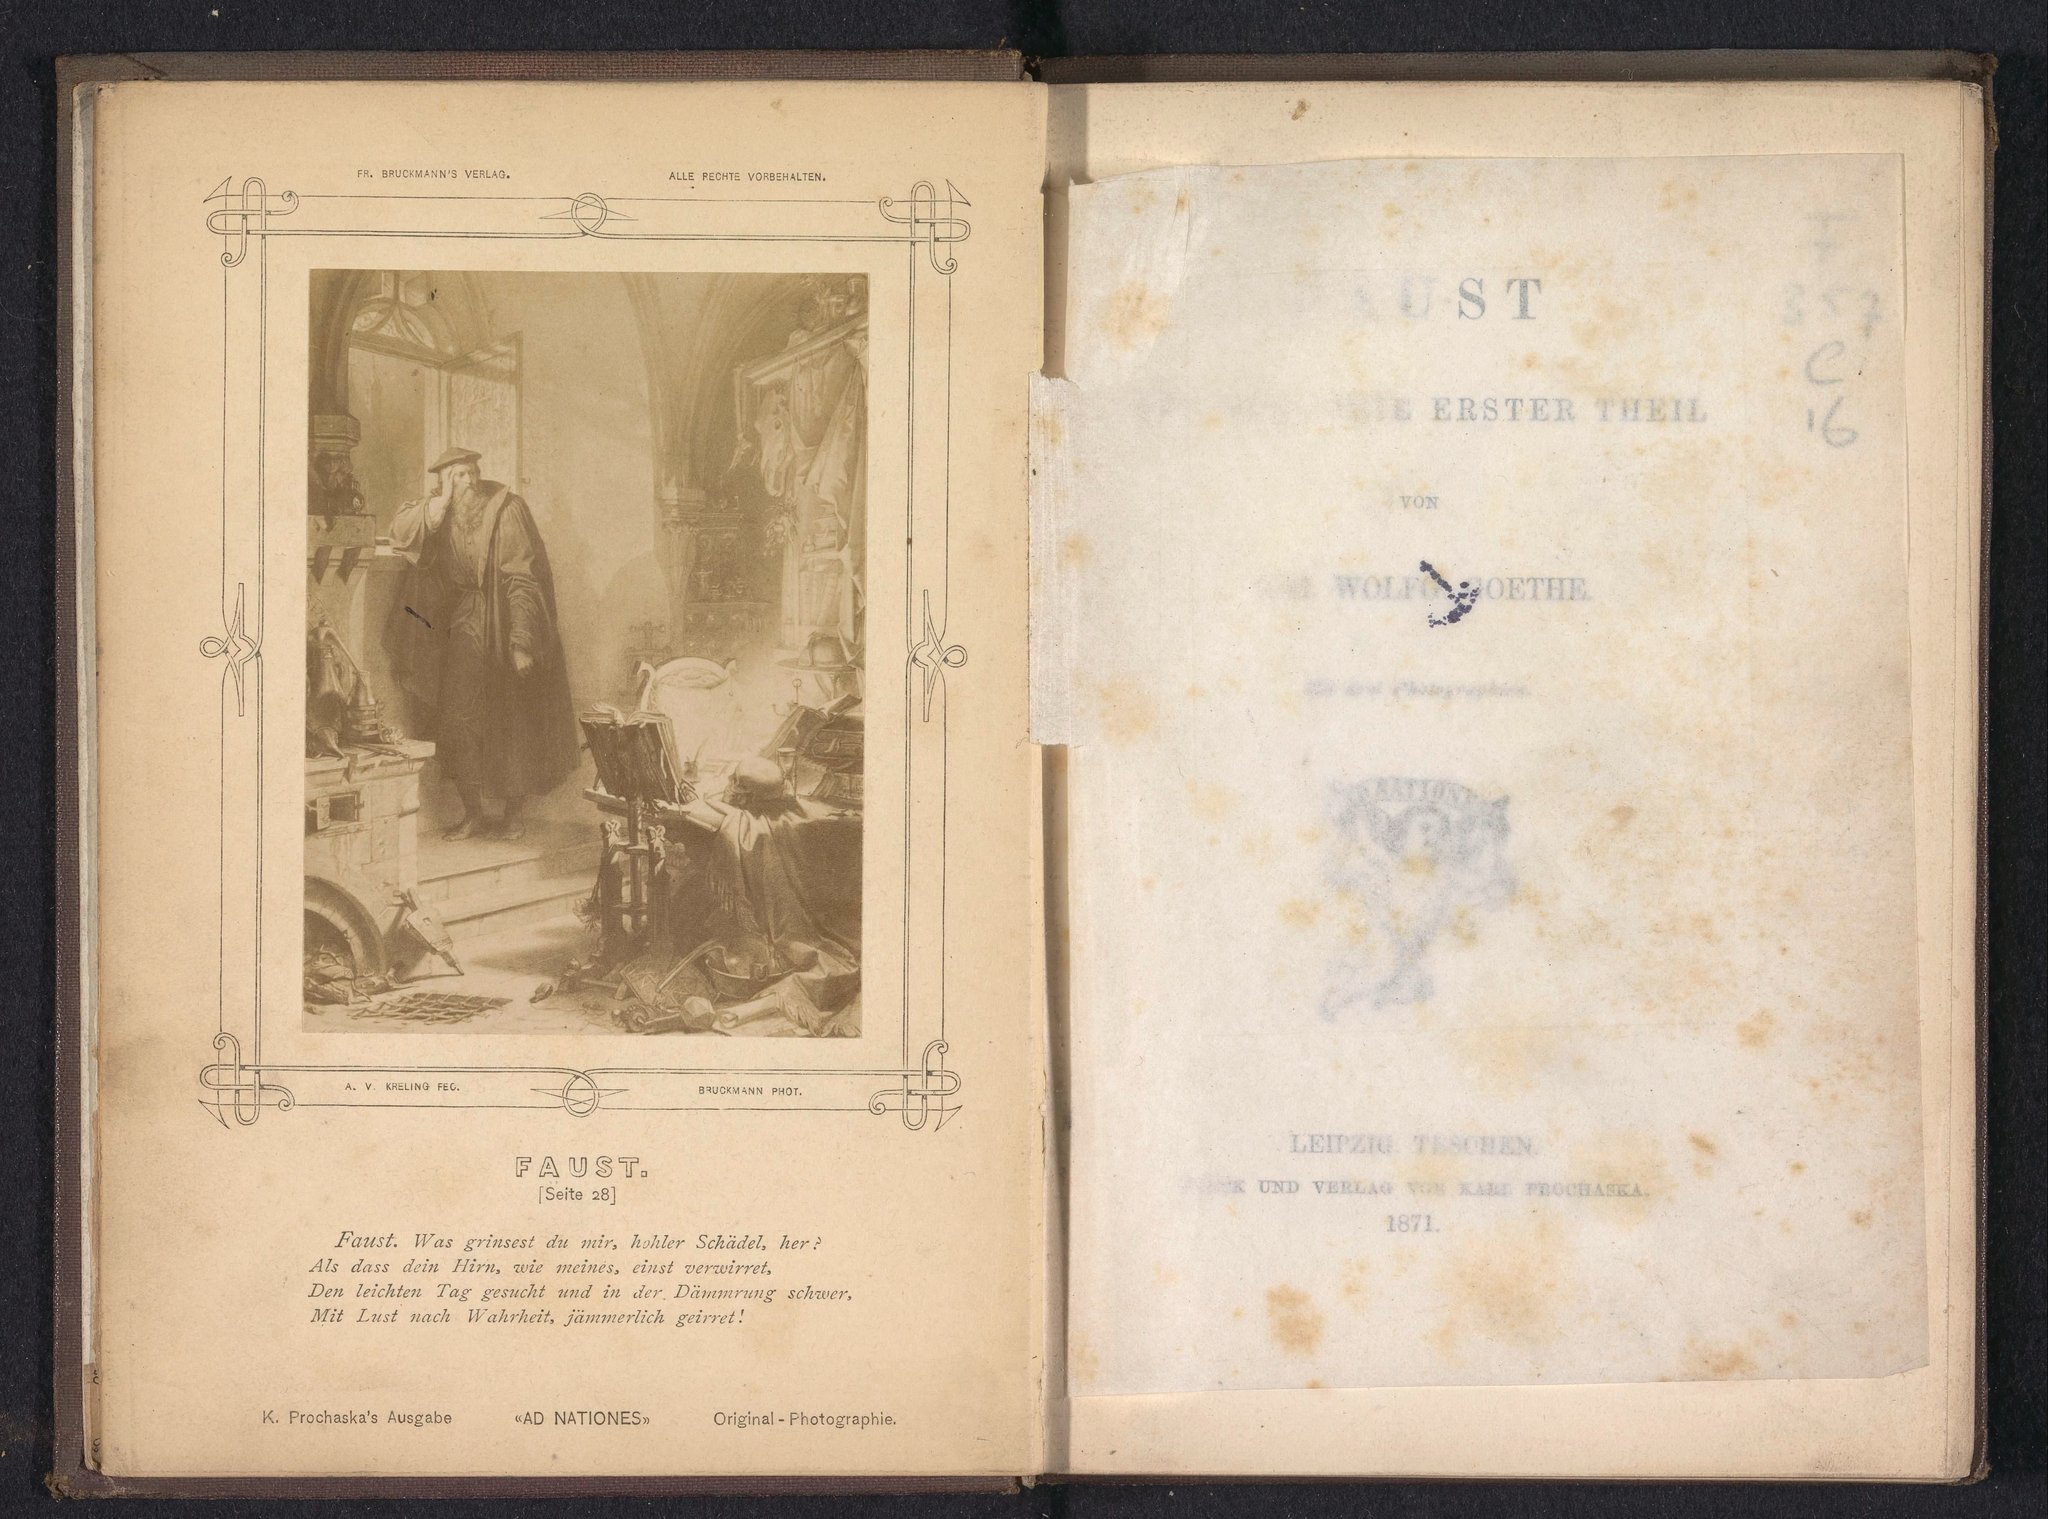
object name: photograph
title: Fotoreproductie van een schilderij, voorstellende Faust filosofeert 's nachts in zijn werkkamer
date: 1866-1871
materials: photographic support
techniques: albumen print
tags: study; 'studiolo'; library, (scenes from) specific works of literature: goethe, faust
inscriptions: inscription: ‘Faust. (...) geirret!’